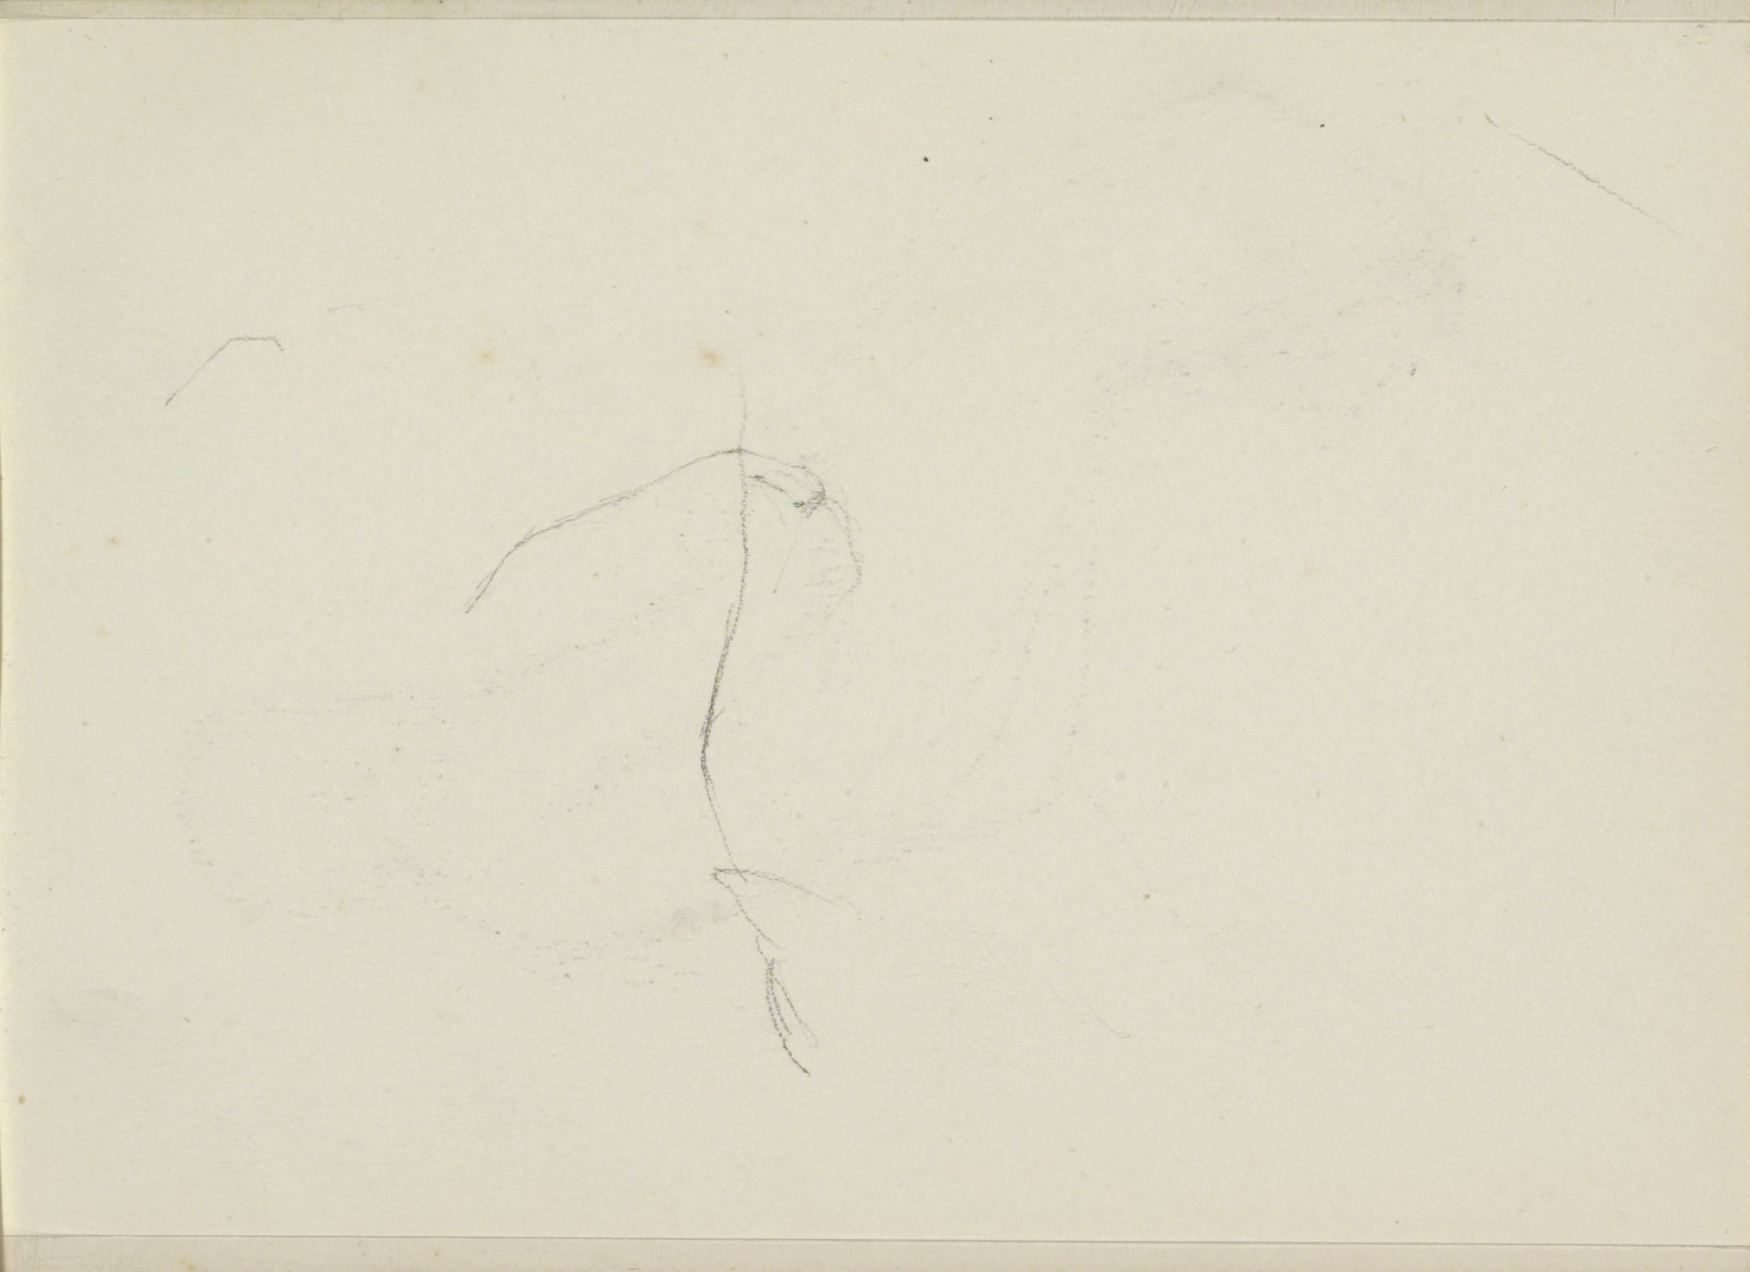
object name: sketchbook leaf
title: Studie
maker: a.a.l. de grammont-hubrecht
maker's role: draughtsman, painter, print maker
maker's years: 1855-1913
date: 1865-1913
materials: chalk, paper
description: Blad 30 recto uit een schetsboek met 38 bladen.